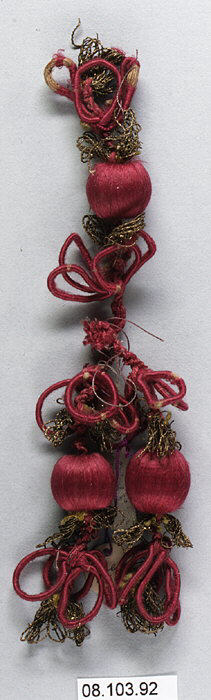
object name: tassel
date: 1801-1900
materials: metal thread, silk